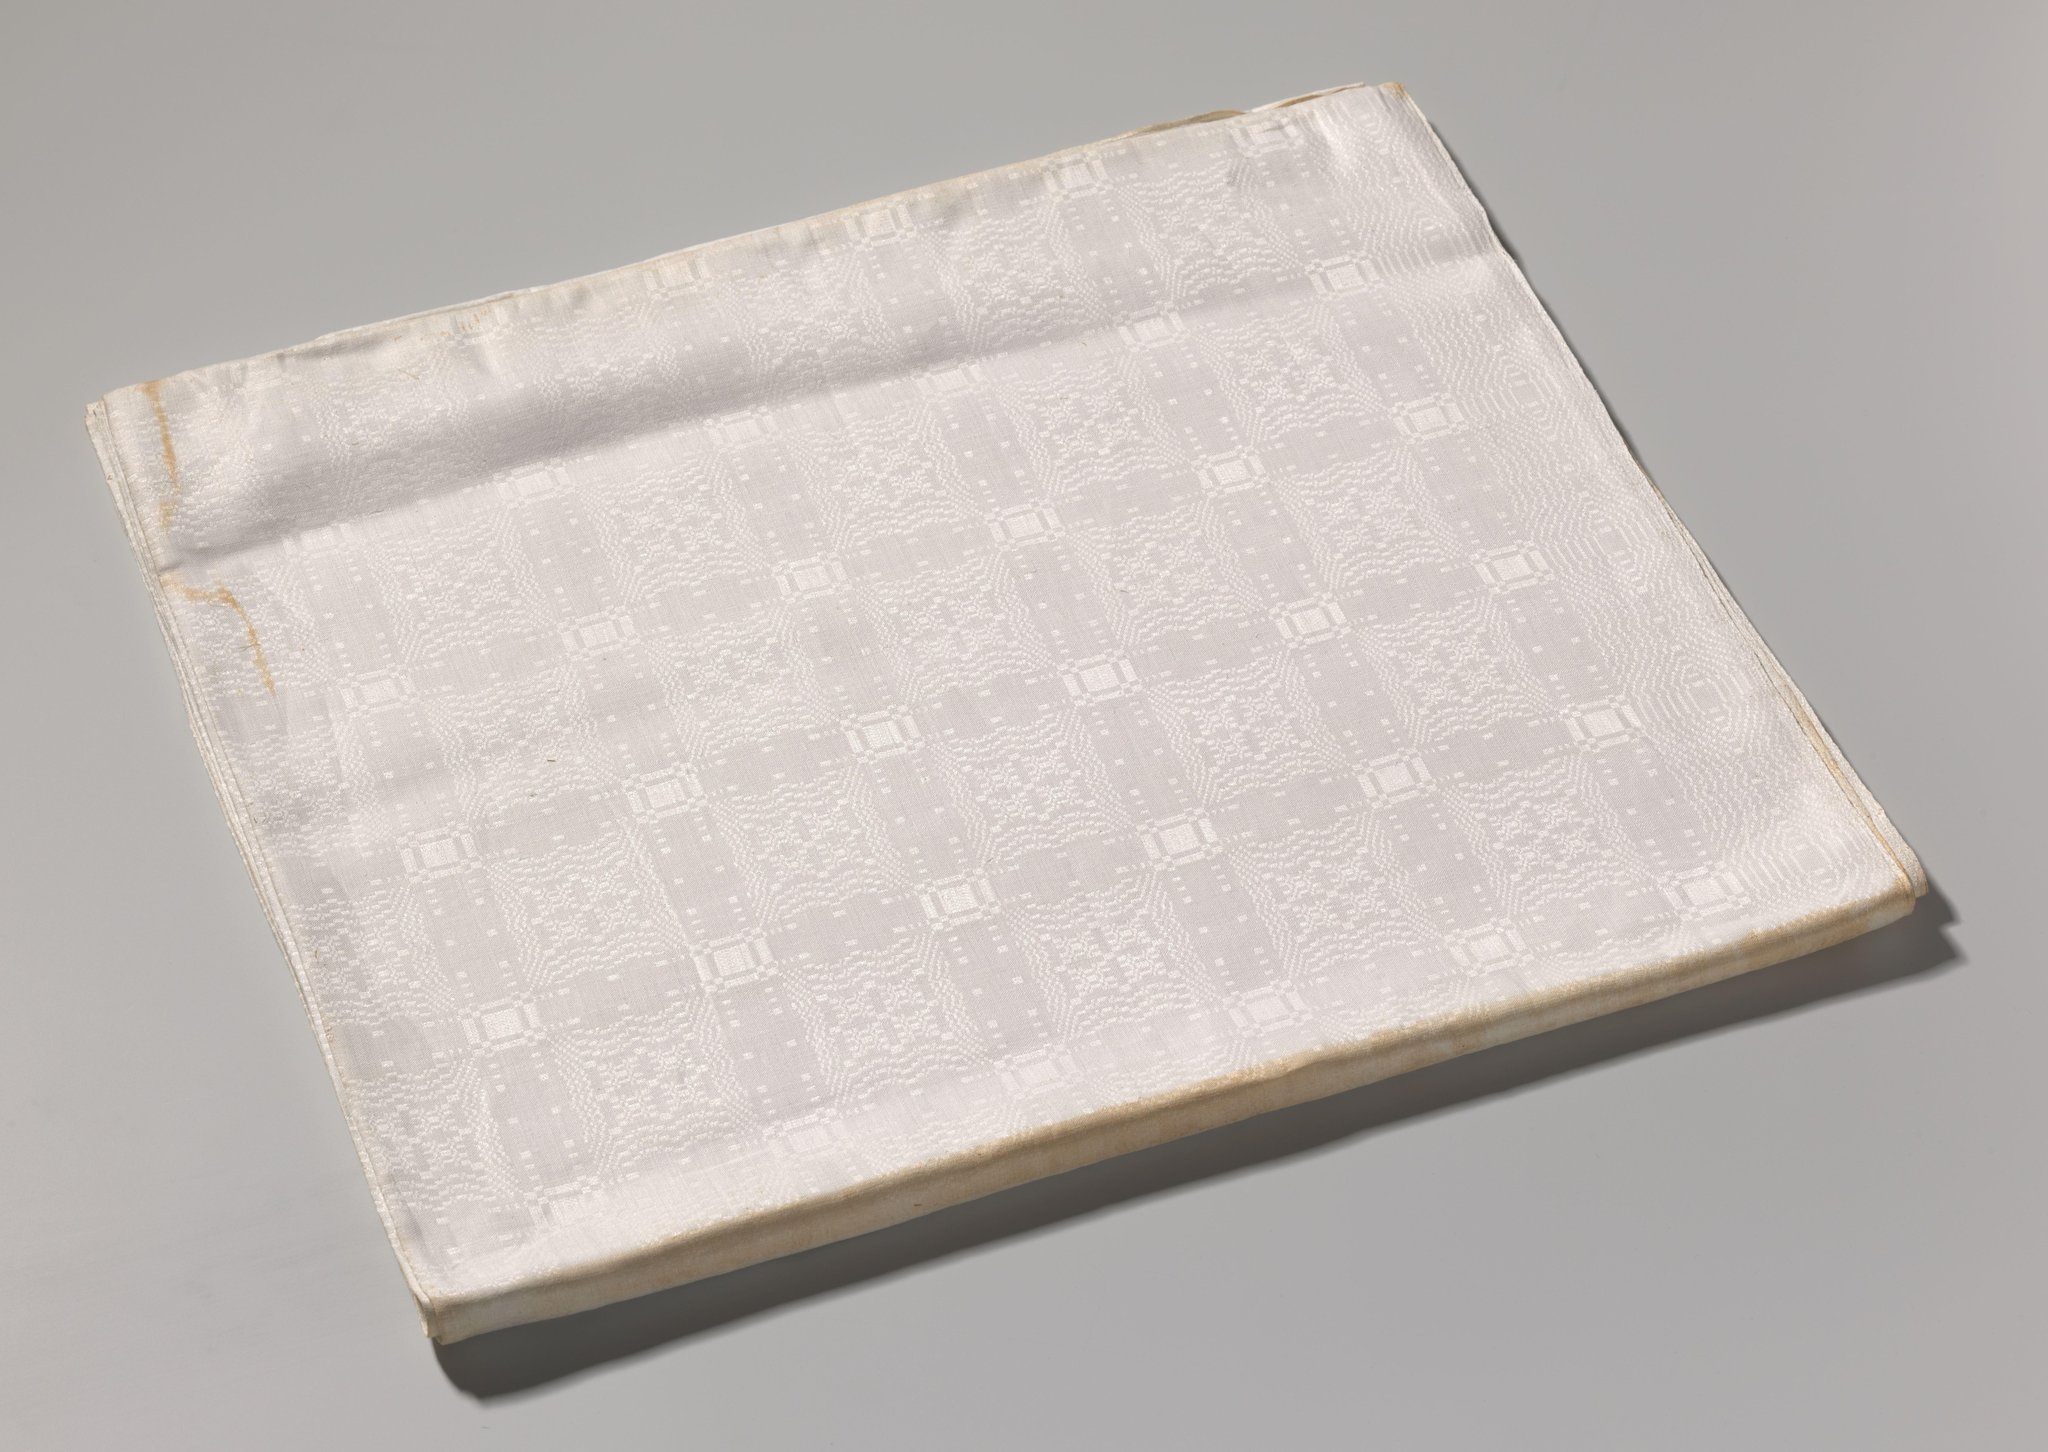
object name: tablecloth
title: Pellen. Merk: kroon IS6.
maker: Anonymous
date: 1692-1735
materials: linen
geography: northern netherlands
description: Tafellaken met pellen patroon, merk kroon IS en 6